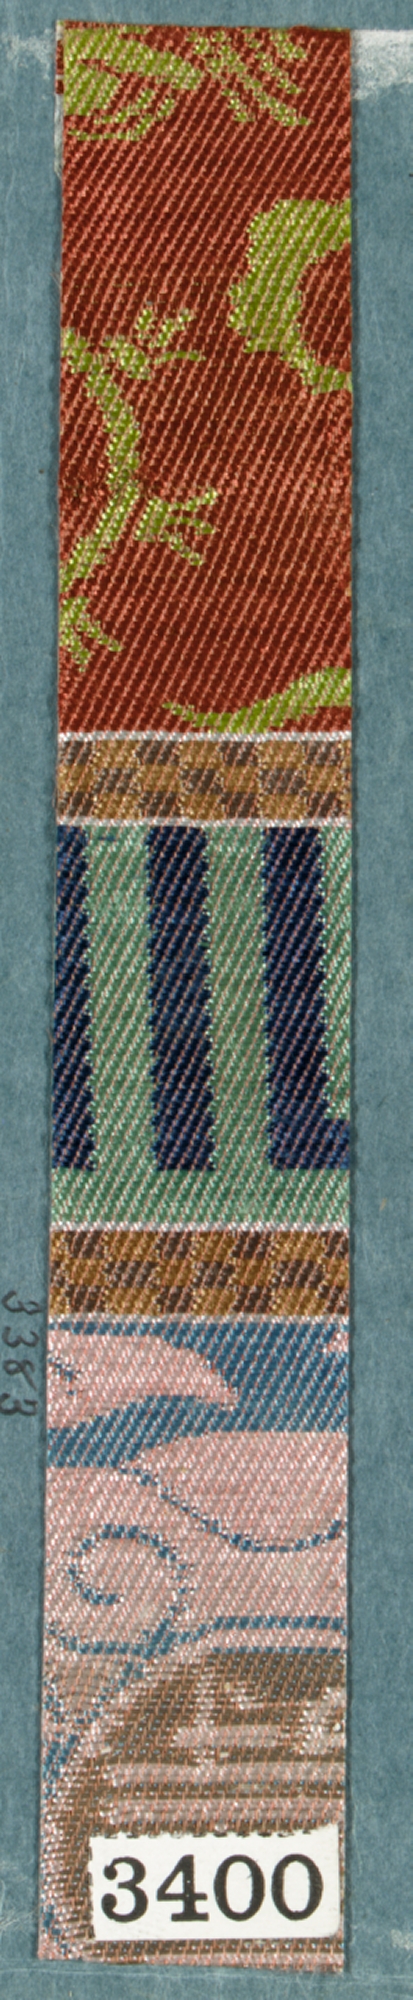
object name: textile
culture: japanese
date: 1801-1900